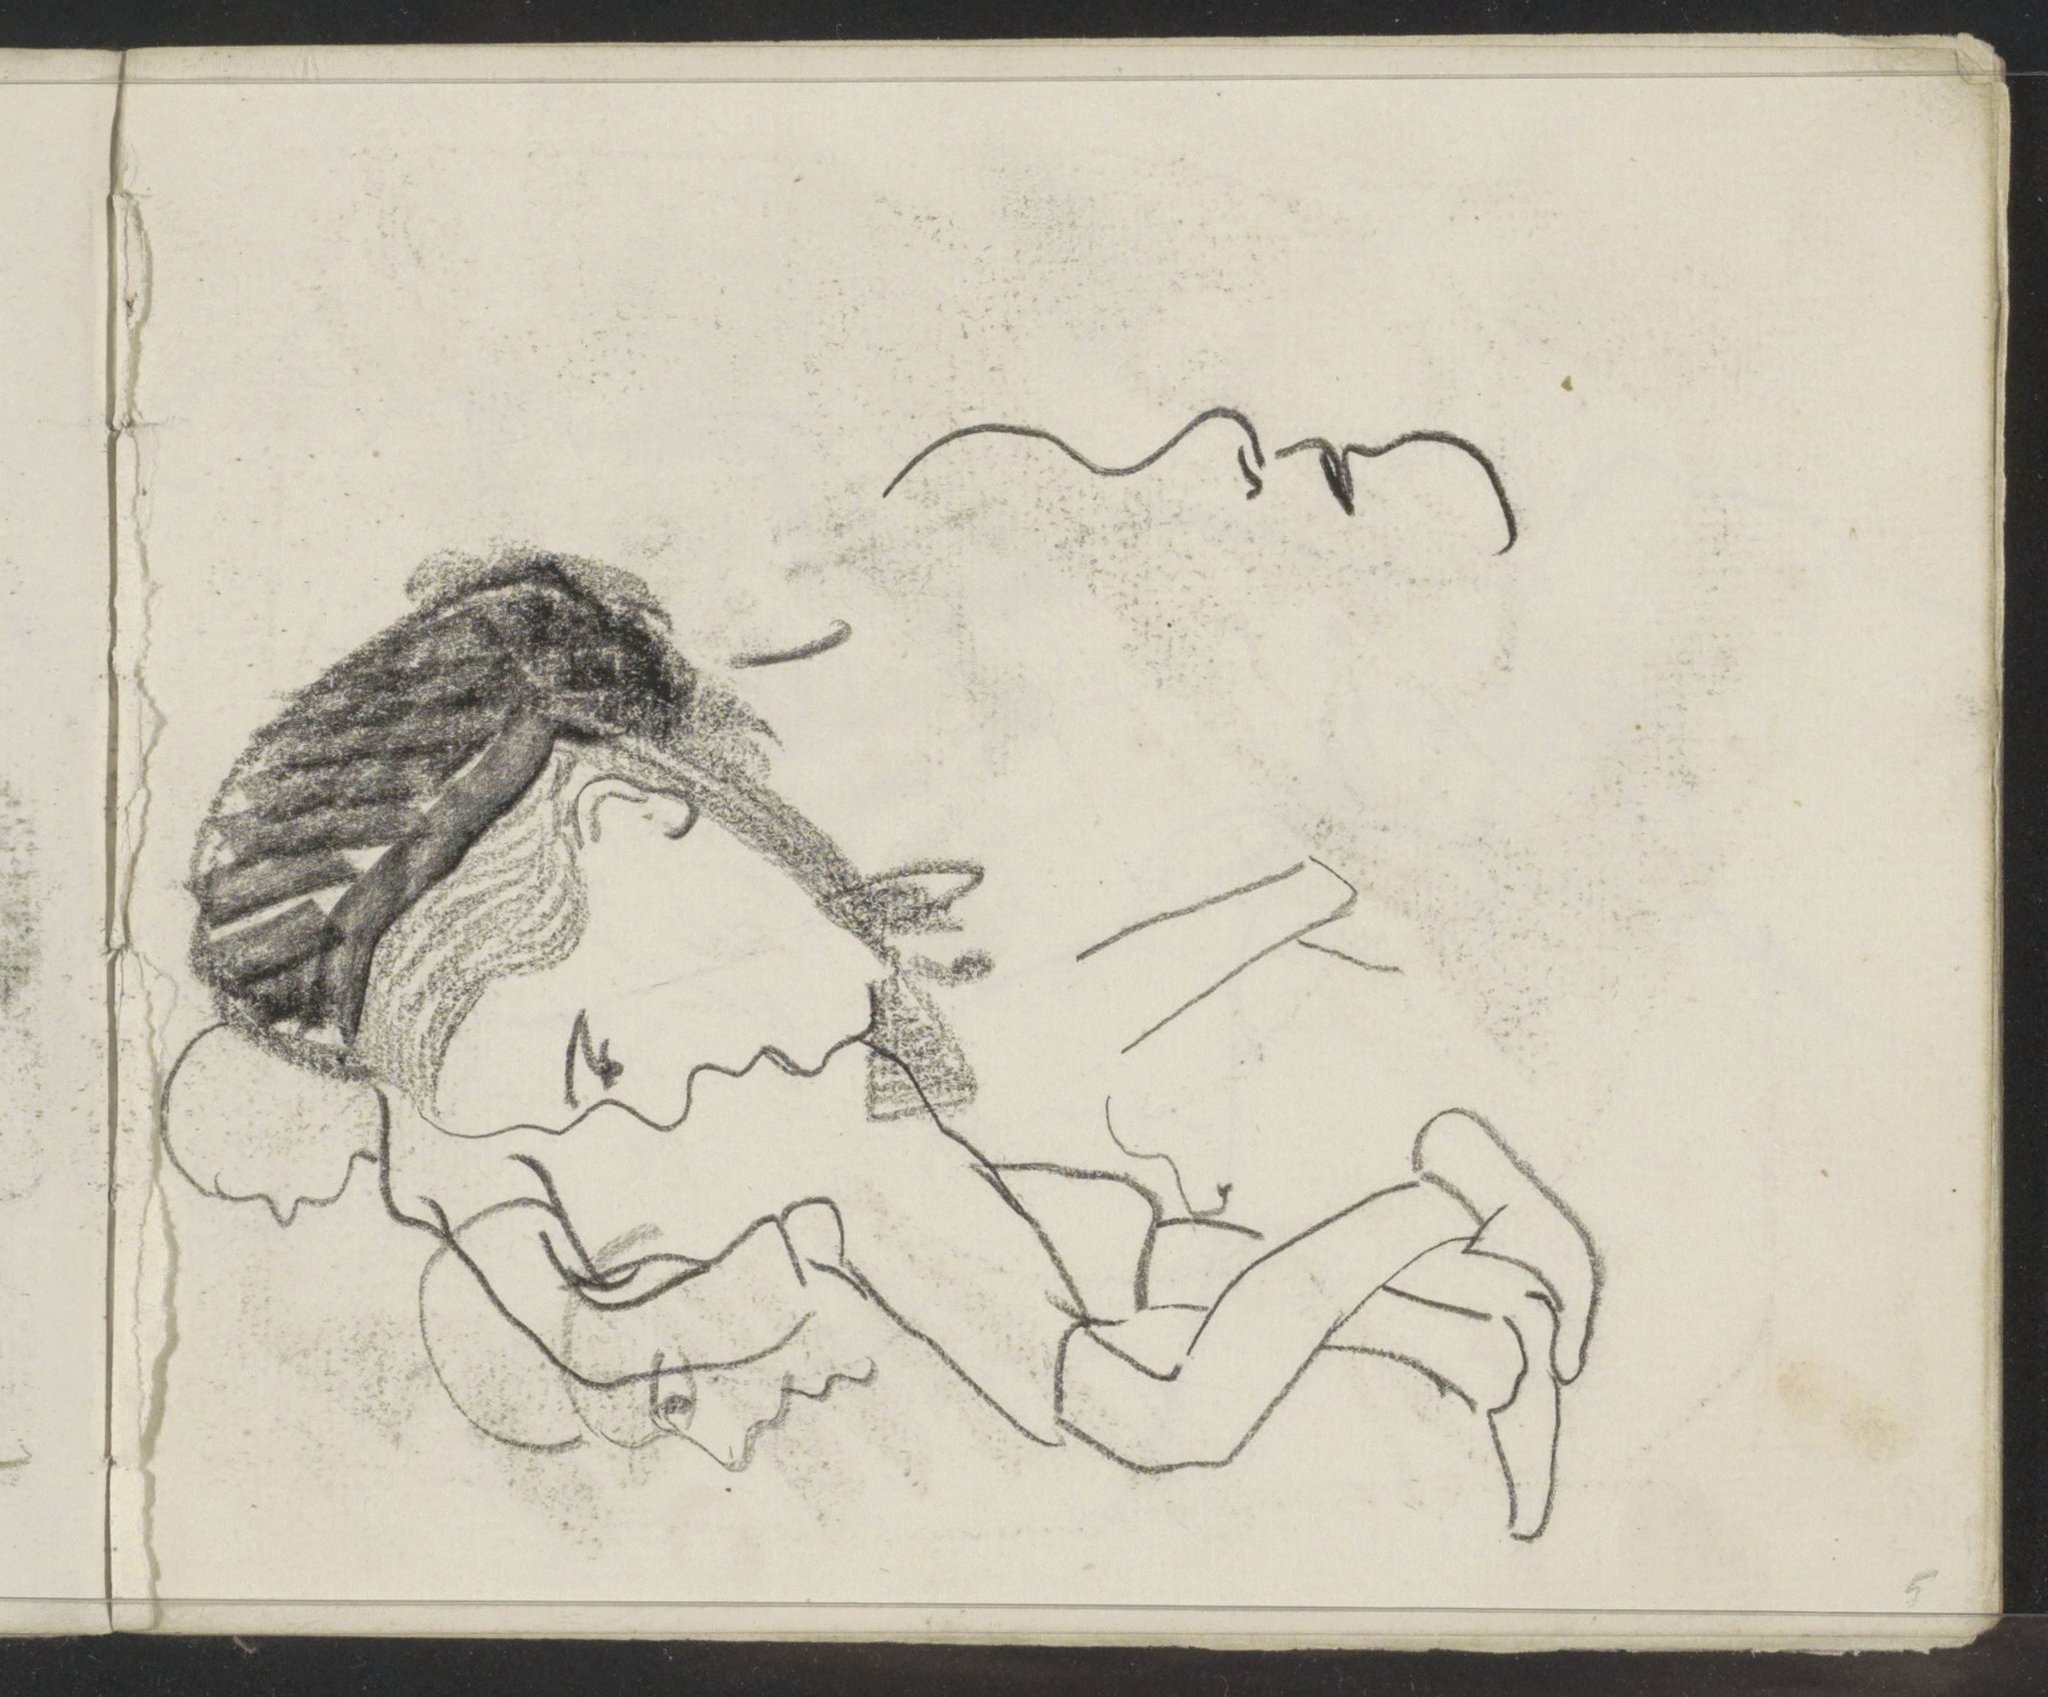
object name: sketchbook leaf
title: Staande man en een vrouwenkop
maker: carel adolph lion cachet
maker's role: draughtsman, print maker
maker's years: 1864-1945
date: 1895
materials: chalk, paper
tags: standing figure, head (human) (+ female (human being) (not to be used where -aa- is prescribed))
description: De man staat met een arm in zijn zij. De vrouw draagt een hoed. Blad 5 recto uit een schetsboek met 11 bladen.